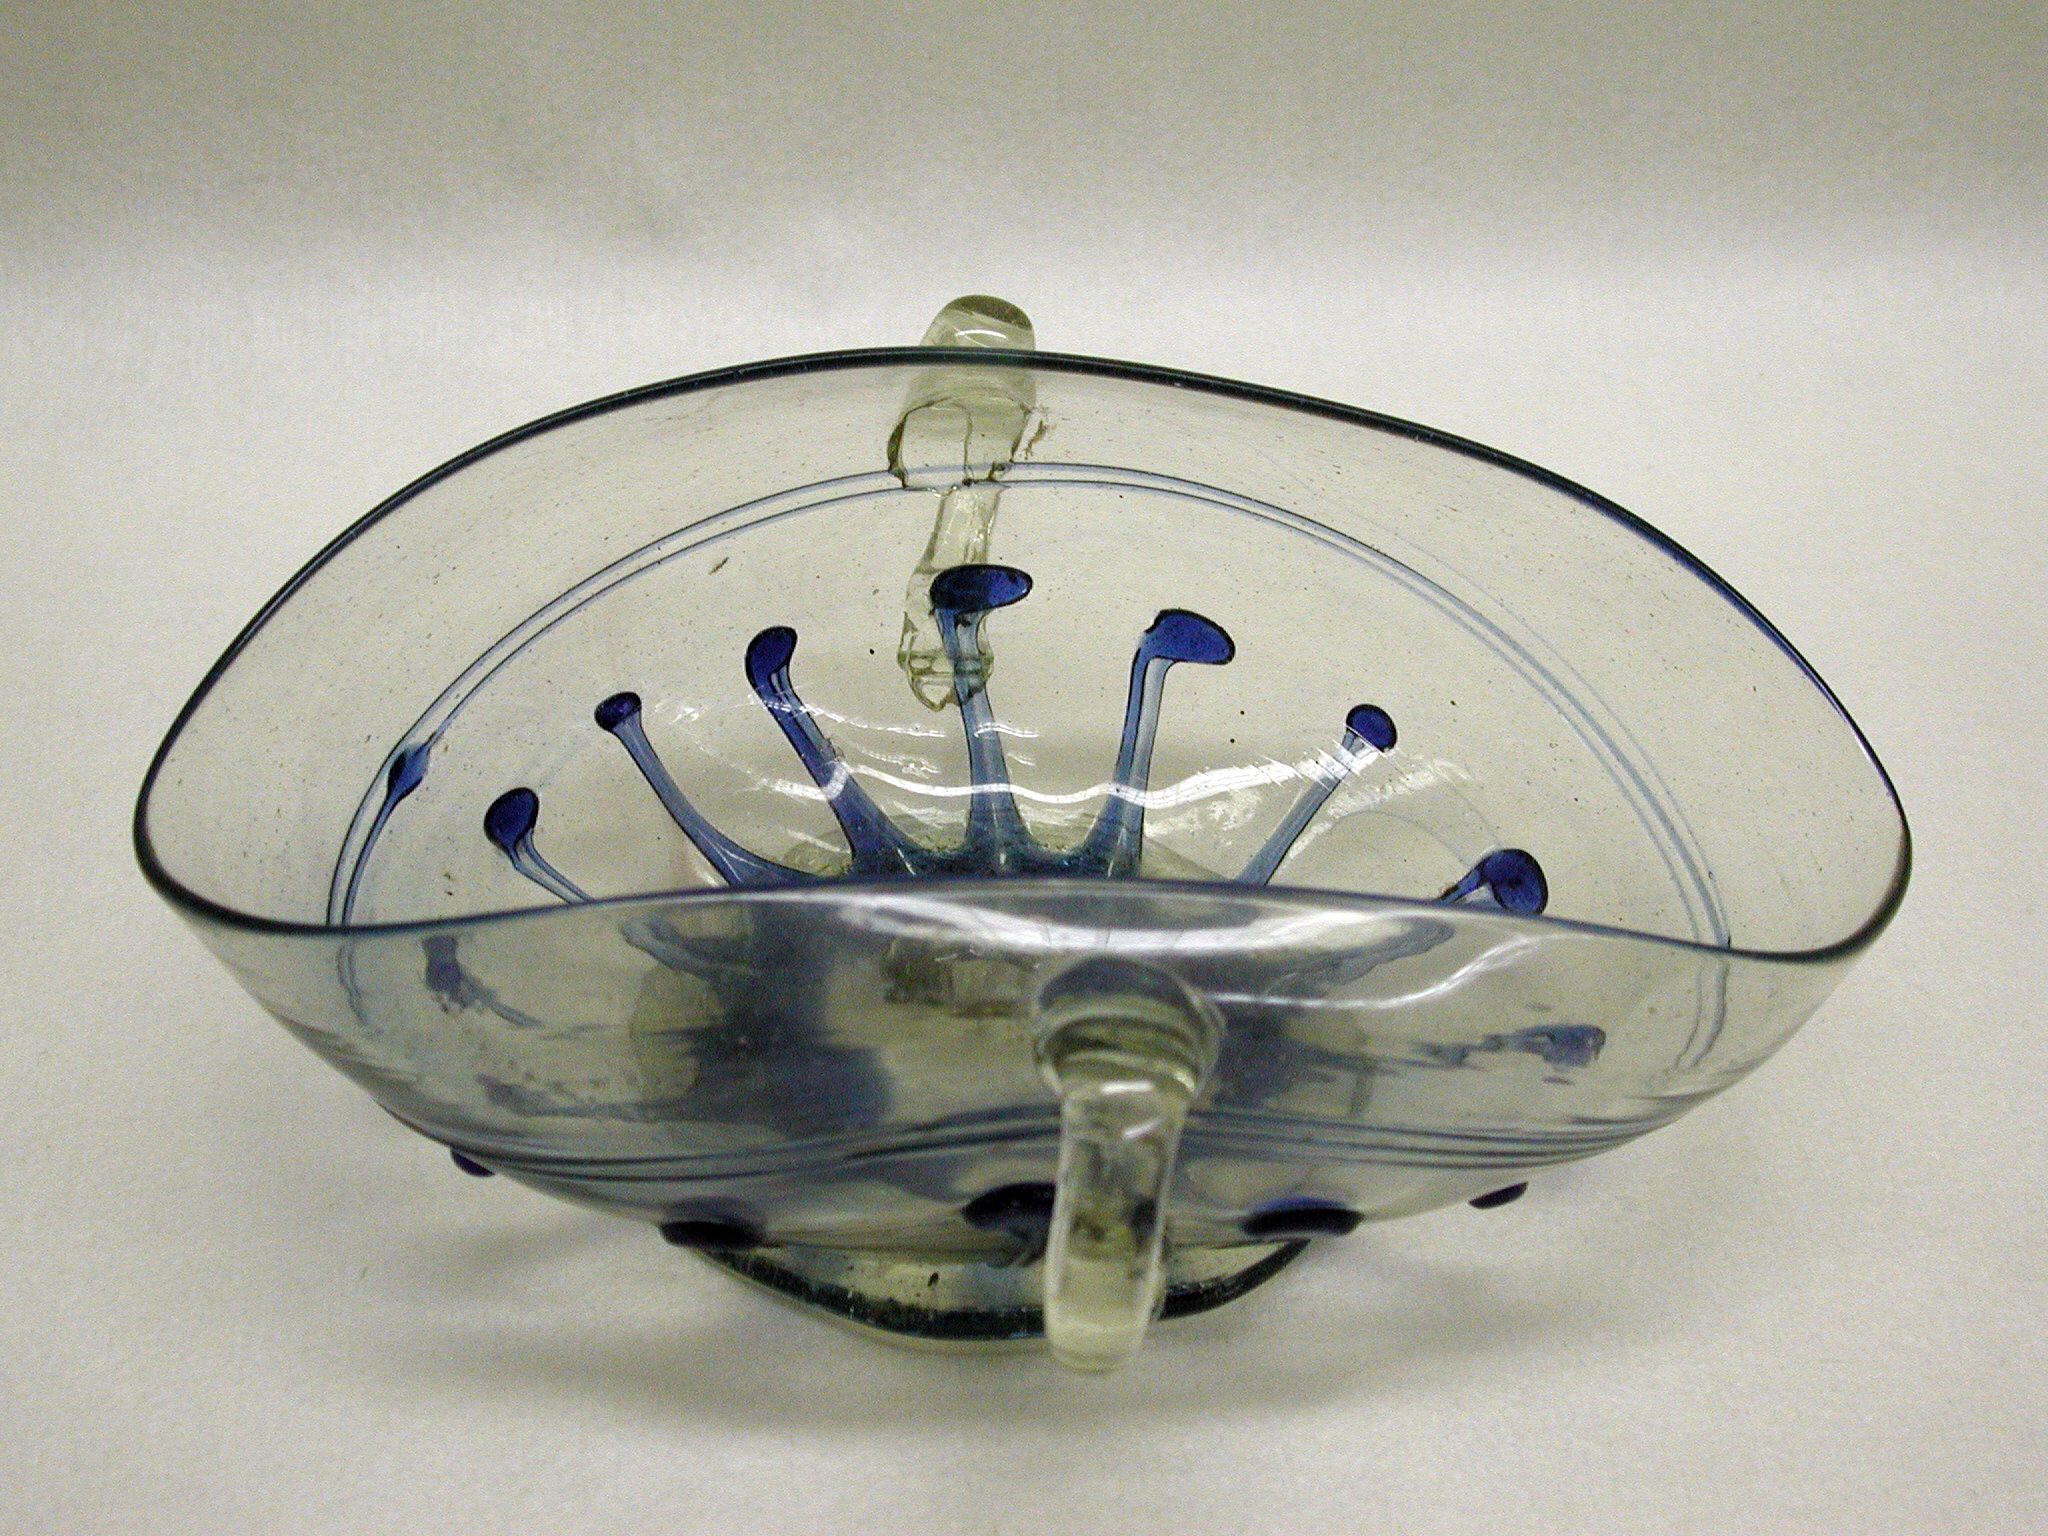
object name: bowl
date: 1701-1800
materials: glass